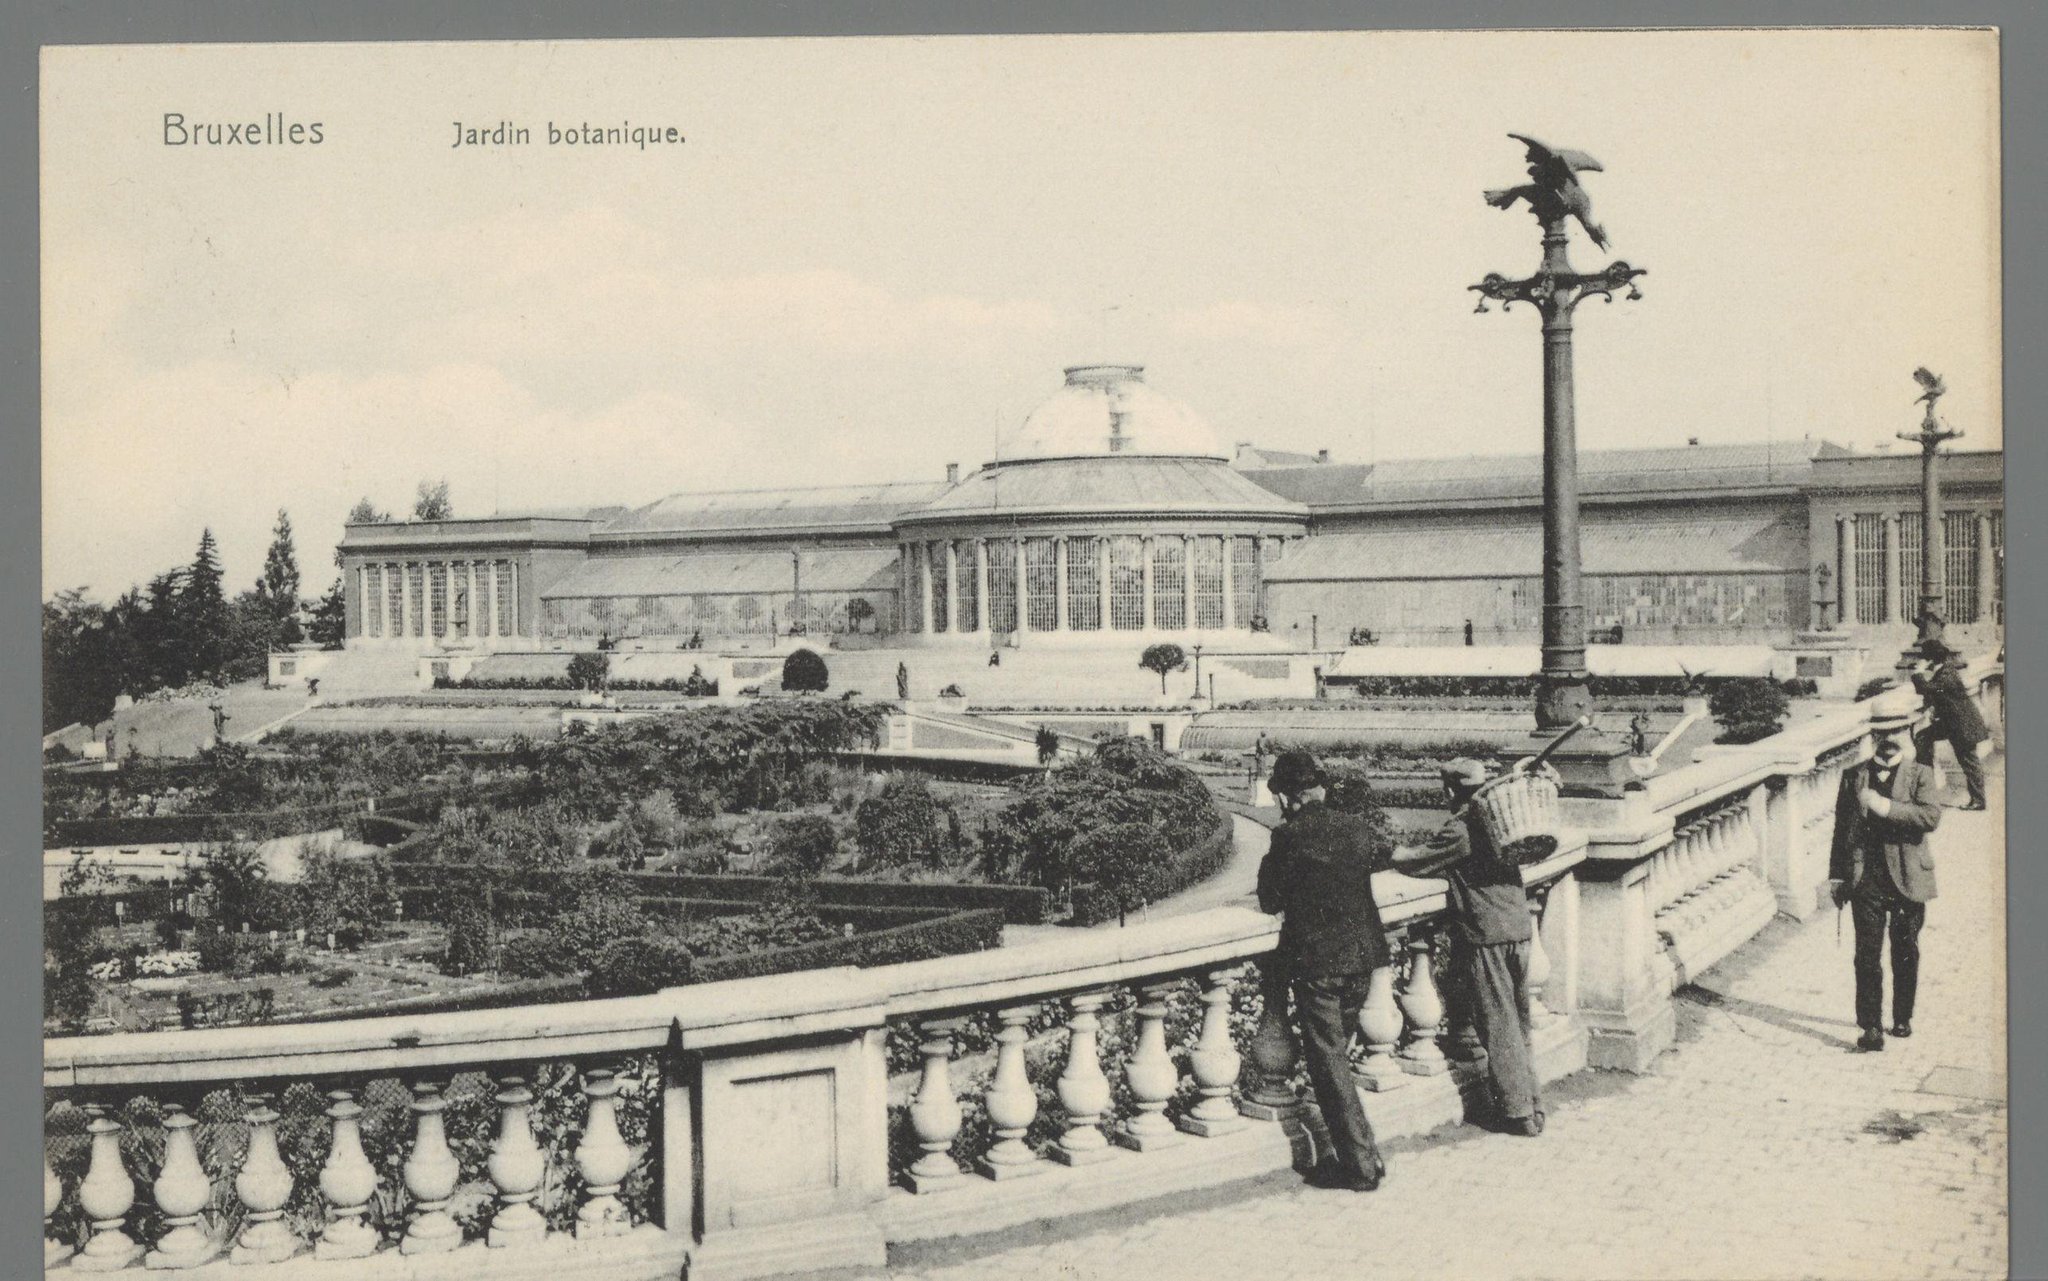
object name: photomechanical print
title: Bruxelles. Jardin Botanique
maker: Anonymous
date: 1907-1913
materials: cardboard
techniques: photograph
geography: sint-joost-ten-node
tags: public gardens, park (+ city(-scape) with figures, staffage), winter-garden, conservatory